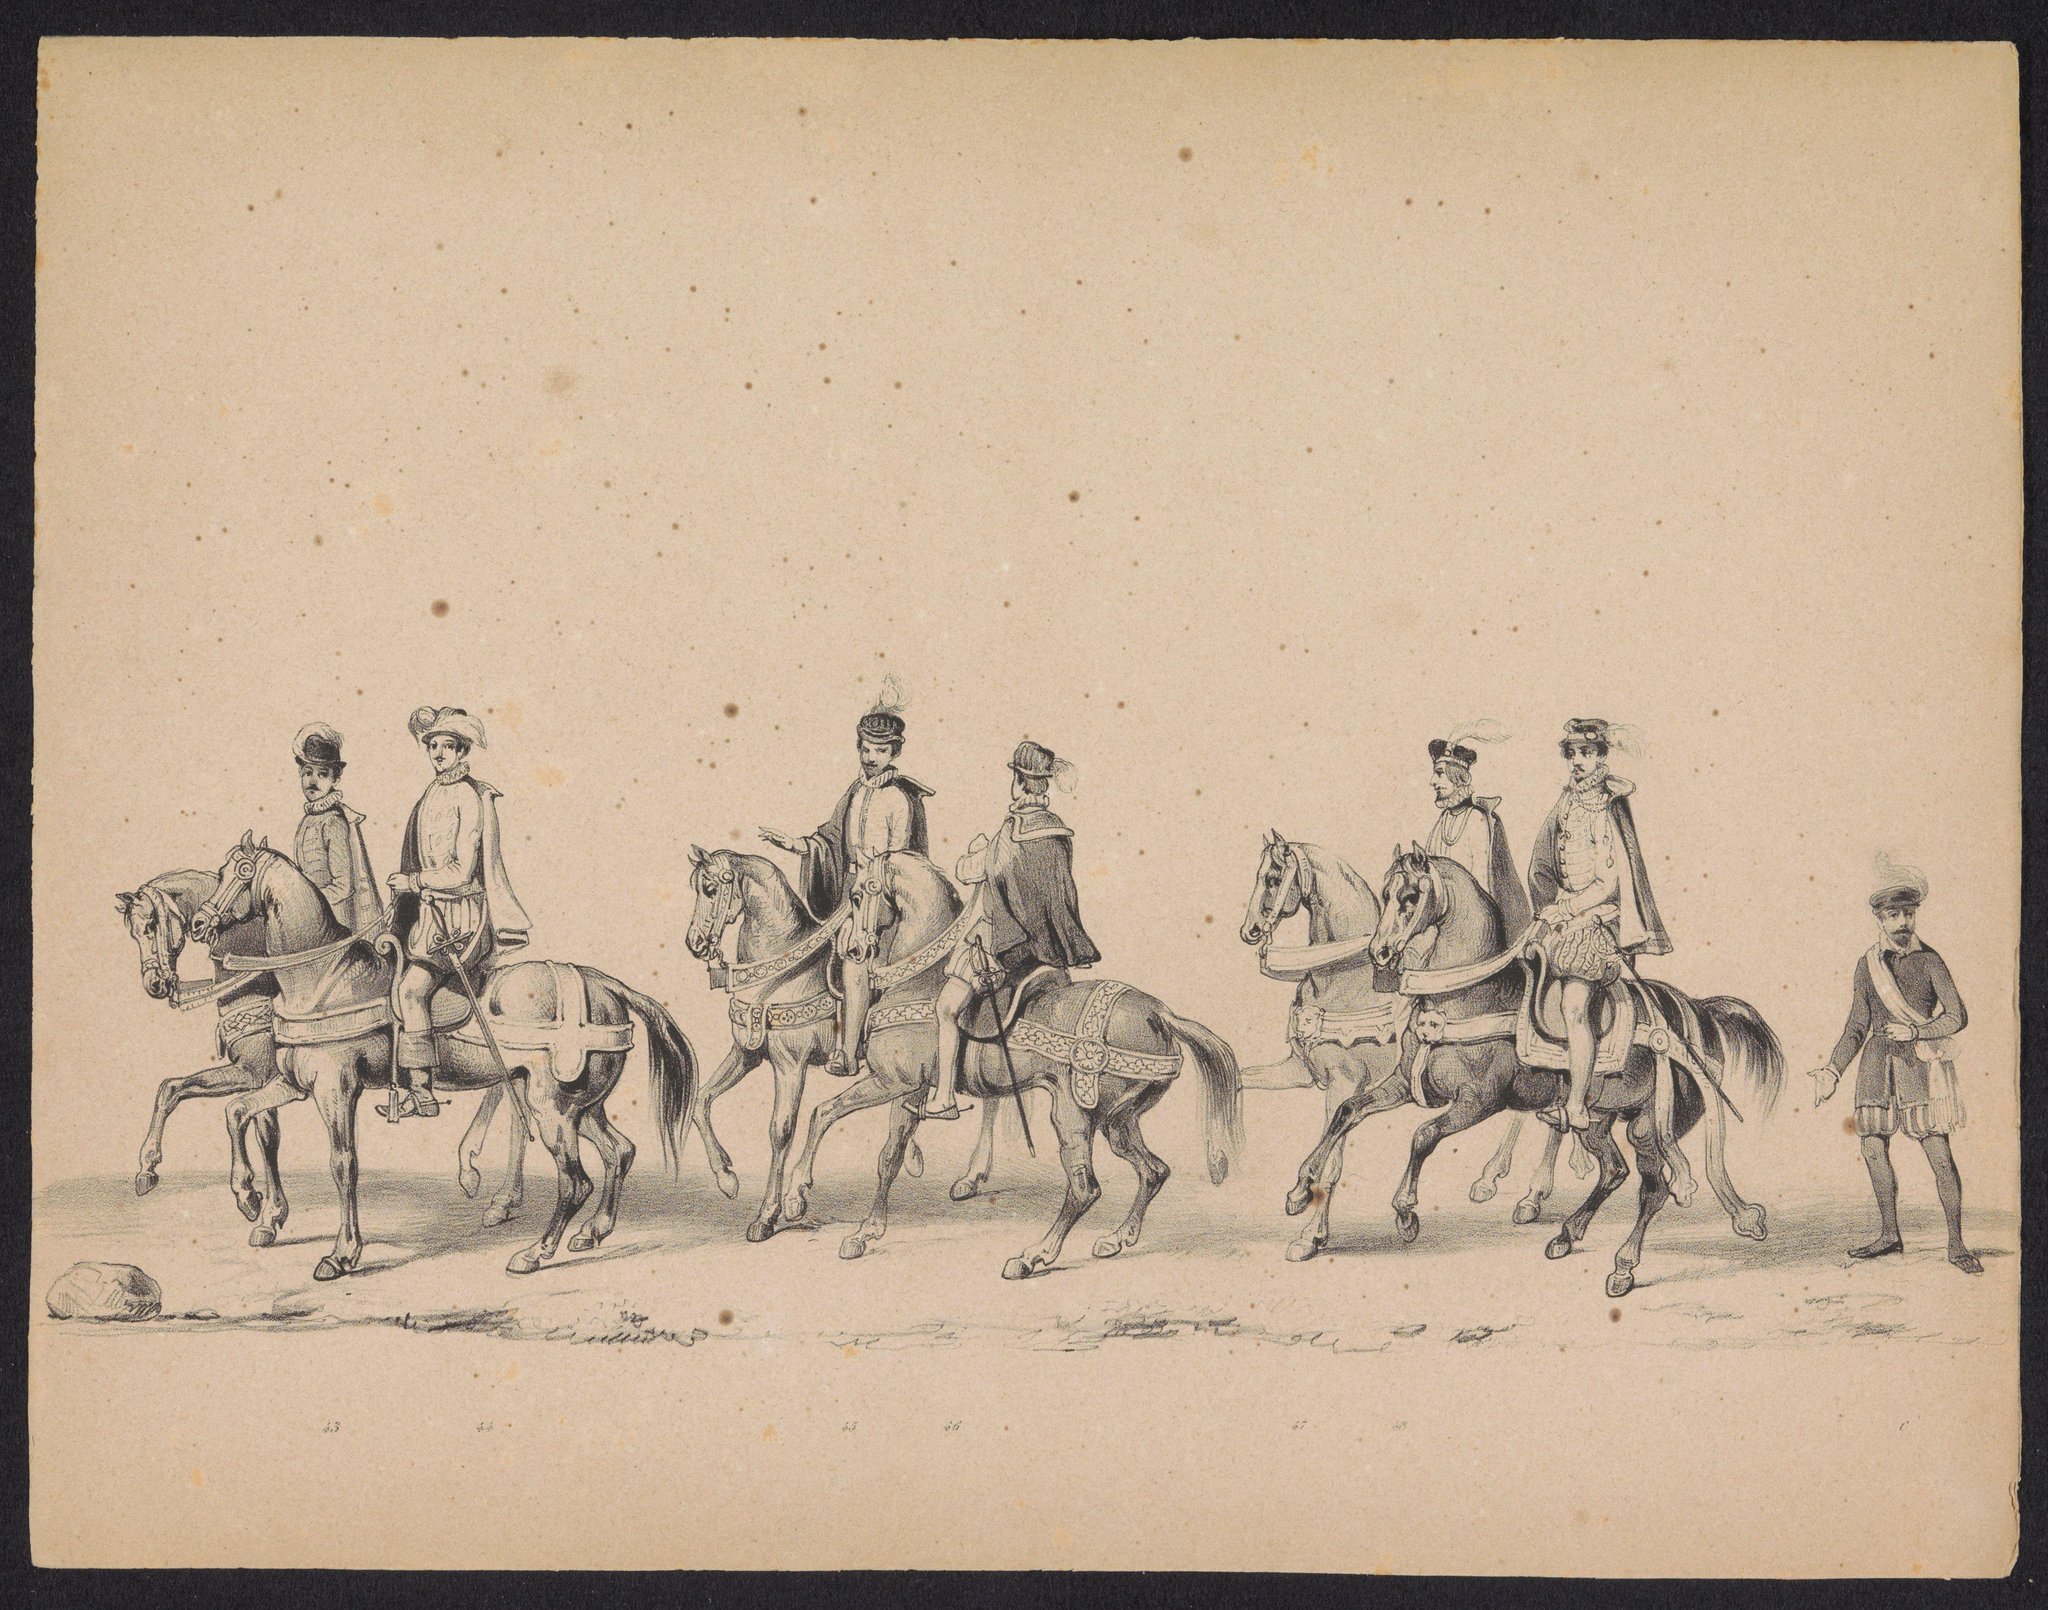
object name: print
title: Afbeelding van den gecostumeerden optogt, voorstellende den in togt van Philips II, Prins van Spanje, in Utrecht, den 3en October 1549, gehouden den 17en Junij 1846, door H.H. Studenten der Utrechtsche Hoogeschool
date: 1847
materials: paper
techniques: lithograph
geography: netherlands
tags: philip ii of spain, students' pageant, costumes used in pageants, utrecht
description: Historische gekostumeerde optocht van de studenten van de Utrechtse Hogeschool gehouden op 17 juni 1846 ter gelegenheid van het 210-jarig bestaan van de Hogeschool. De optocht verbeeldt de intocht van Filips II in Utrecht op 3 oktober 1549. Plaat met de groepen genummerd 43-48. Onderdeel van de serie van 22 aanelkaar te plakken losse bladen.